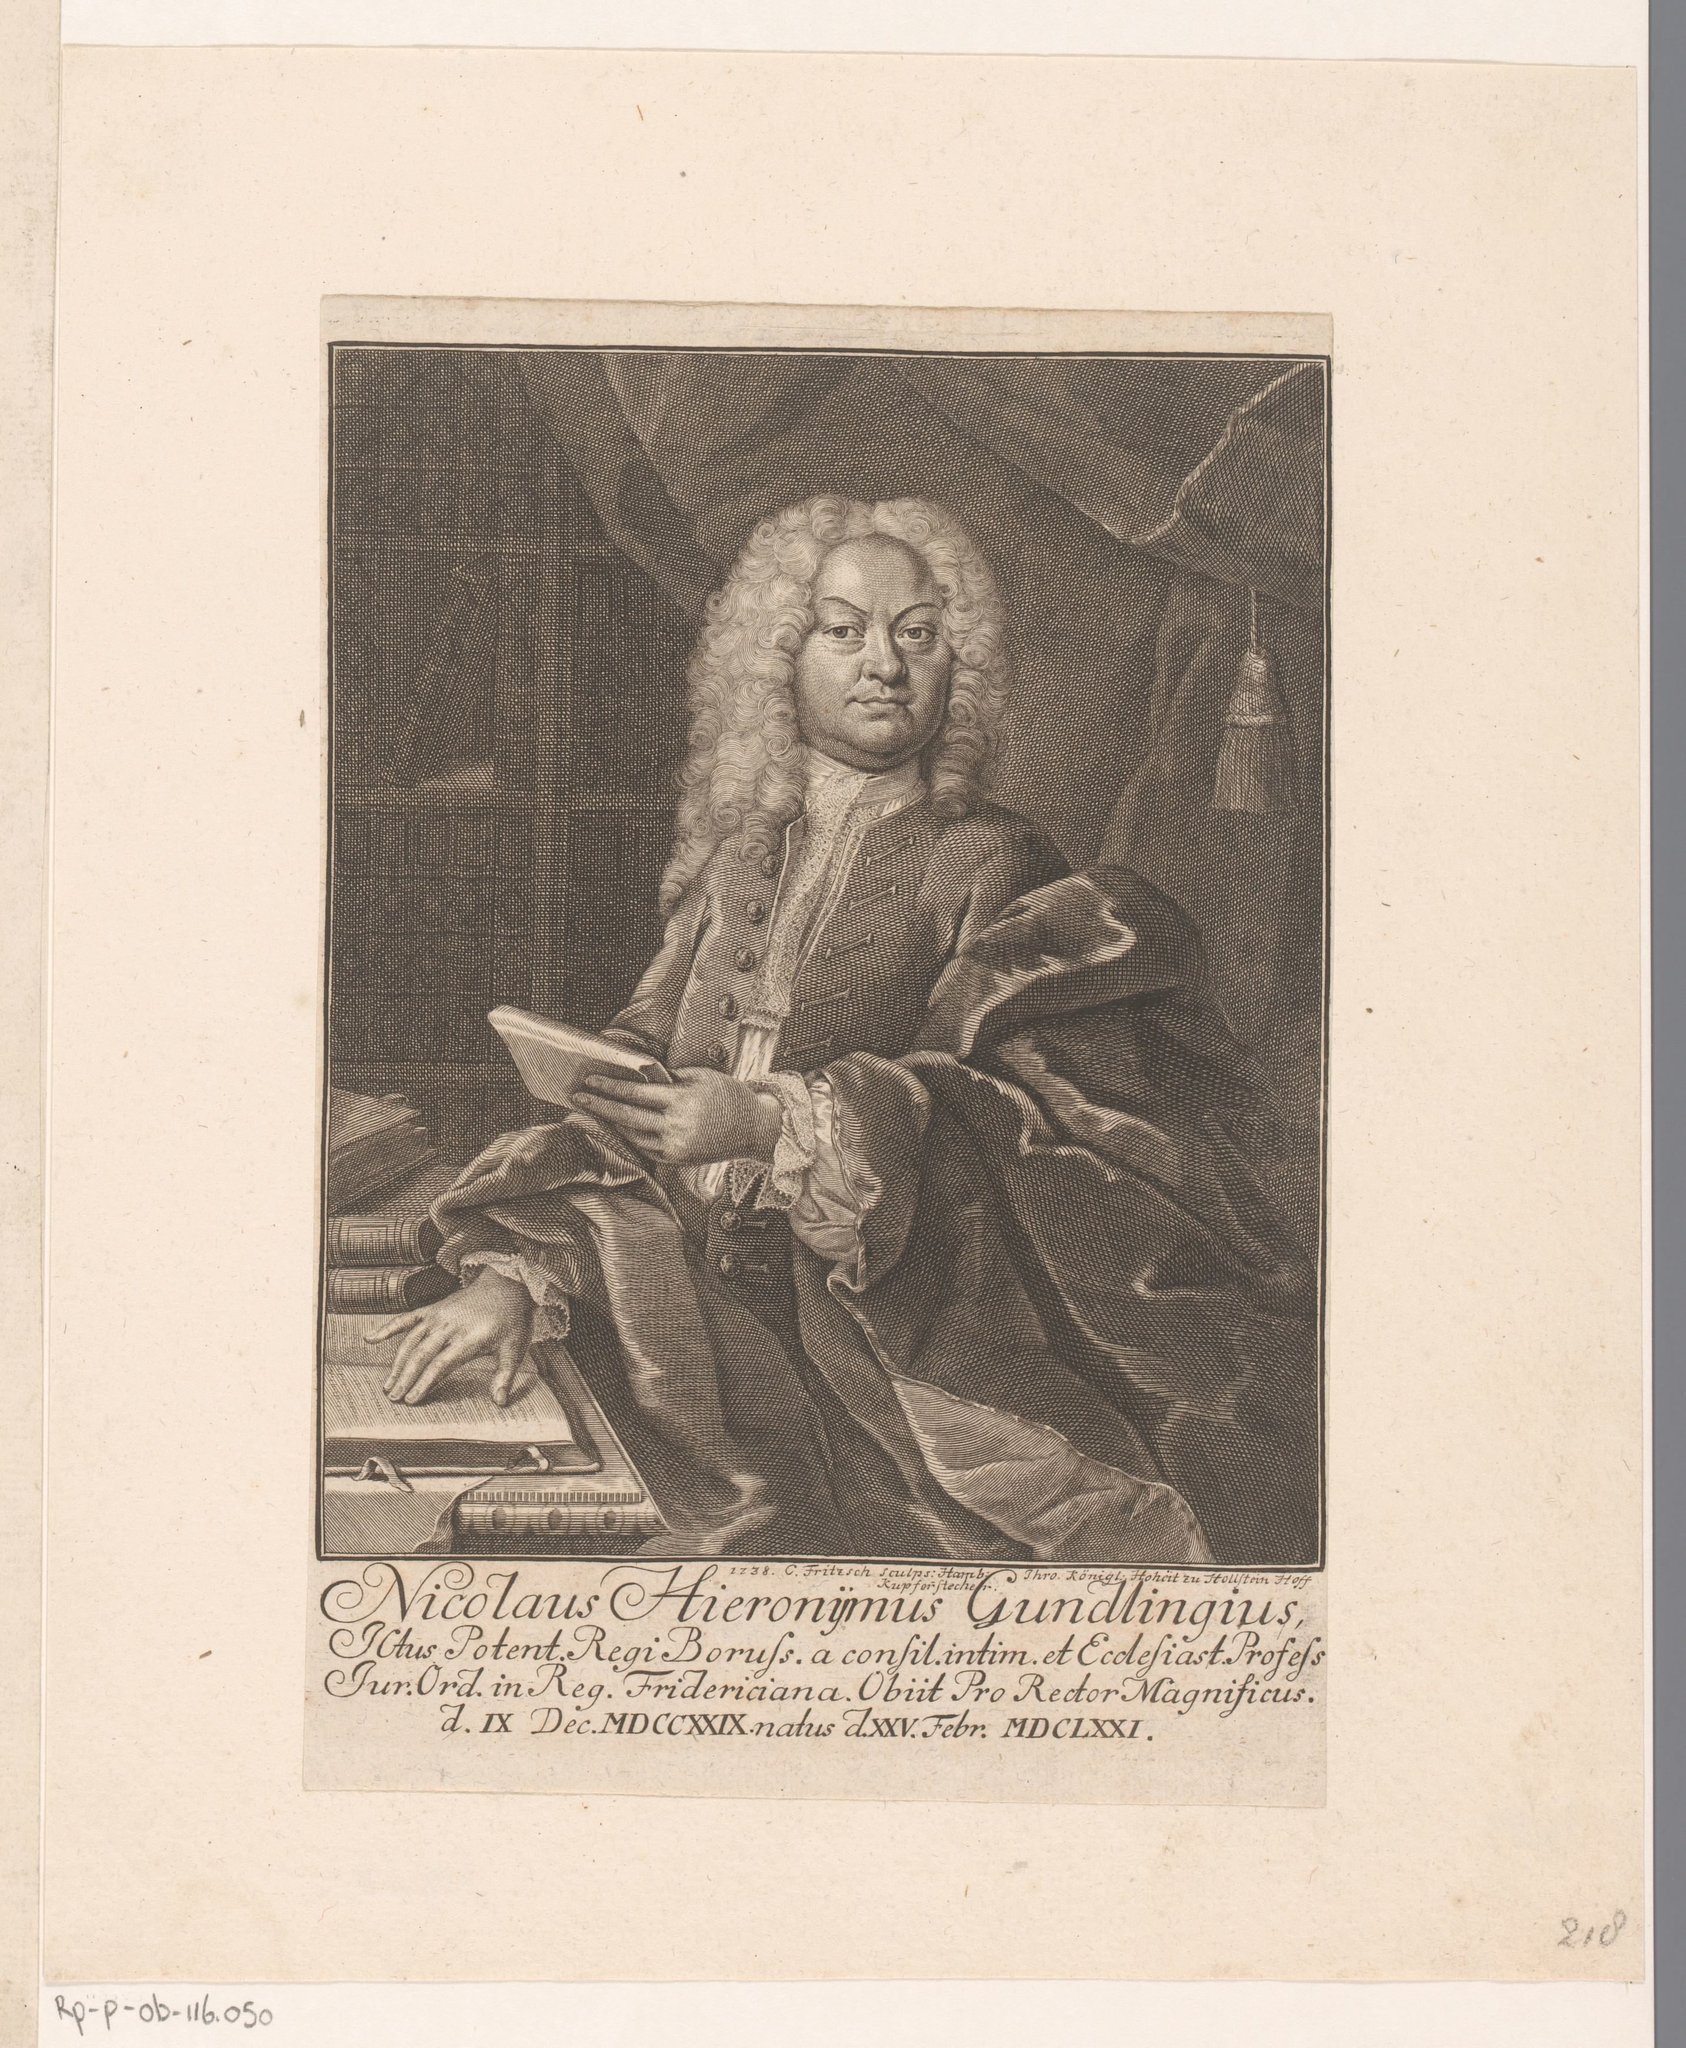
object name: print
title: Portret van Nicolaus Hieronymus Gundling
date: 1738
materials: paper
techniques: engraving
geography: hamburg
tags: bookshelves, historical persons, book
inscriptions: date